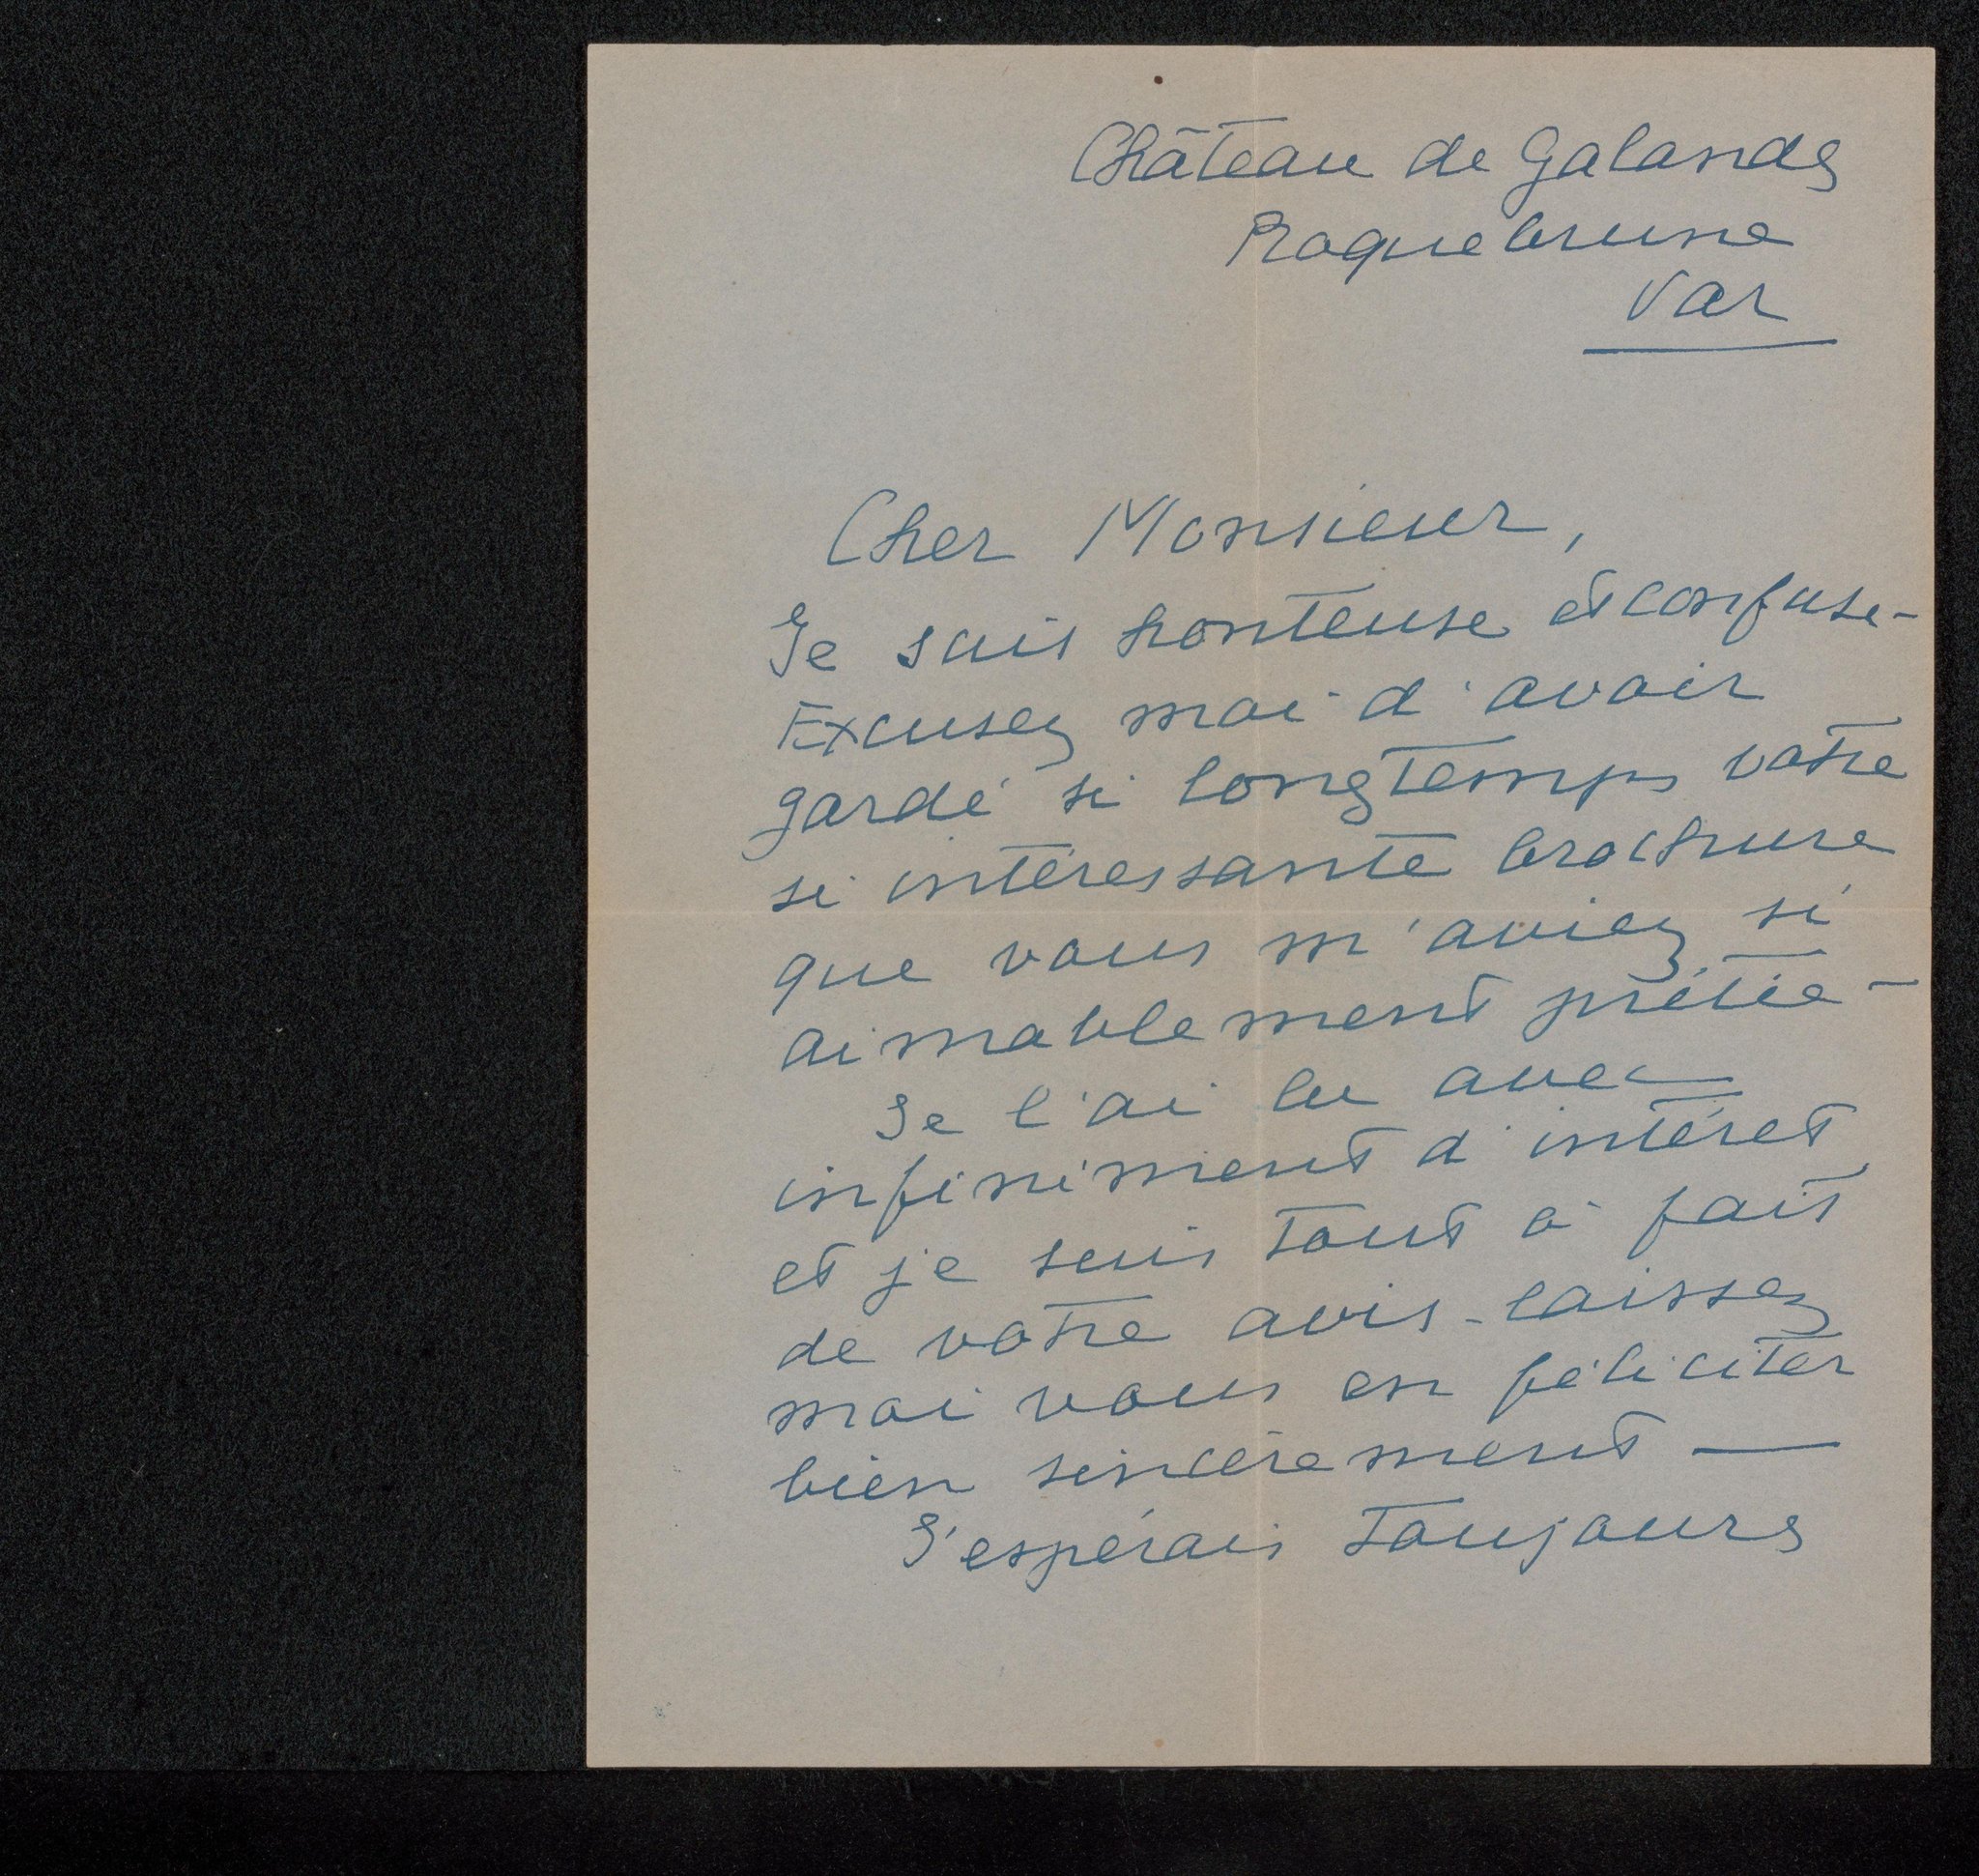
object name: letter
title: Brief aan Philip Zilcken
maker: migueline bernard dattanoux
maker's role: painter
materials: ink, paper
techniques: pen, writing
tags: painter, draughtsman, philip zilcken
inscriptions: seal, collector's mark: ‘RPK’